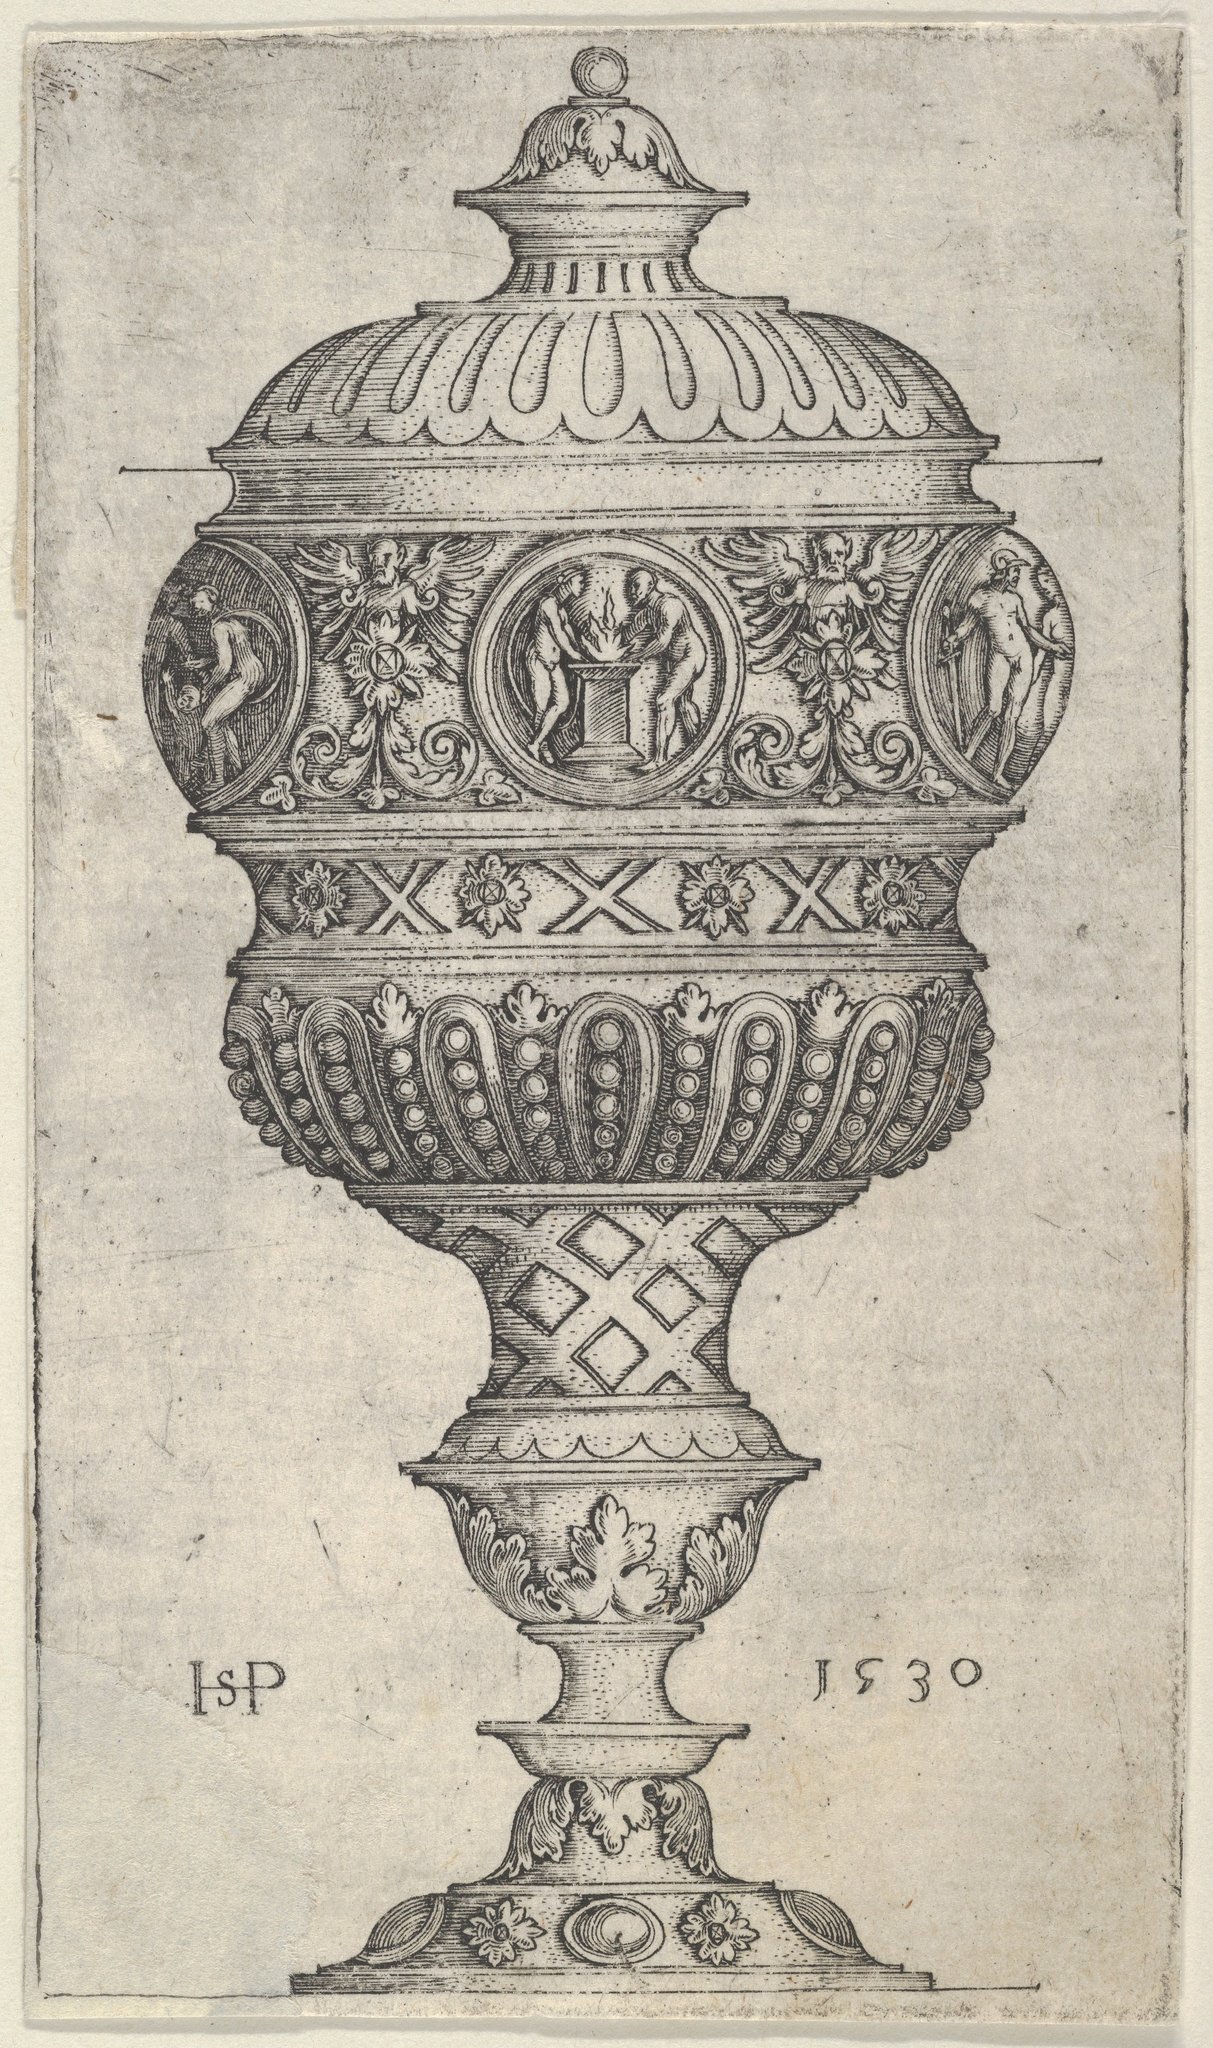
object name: print ornament architecture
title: Goblet with Round Medallions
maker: sebald beham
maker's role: artist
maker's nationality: german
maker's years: 1500-1550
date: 1530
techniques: engraving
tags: medallions,male nudes,drinking glasses